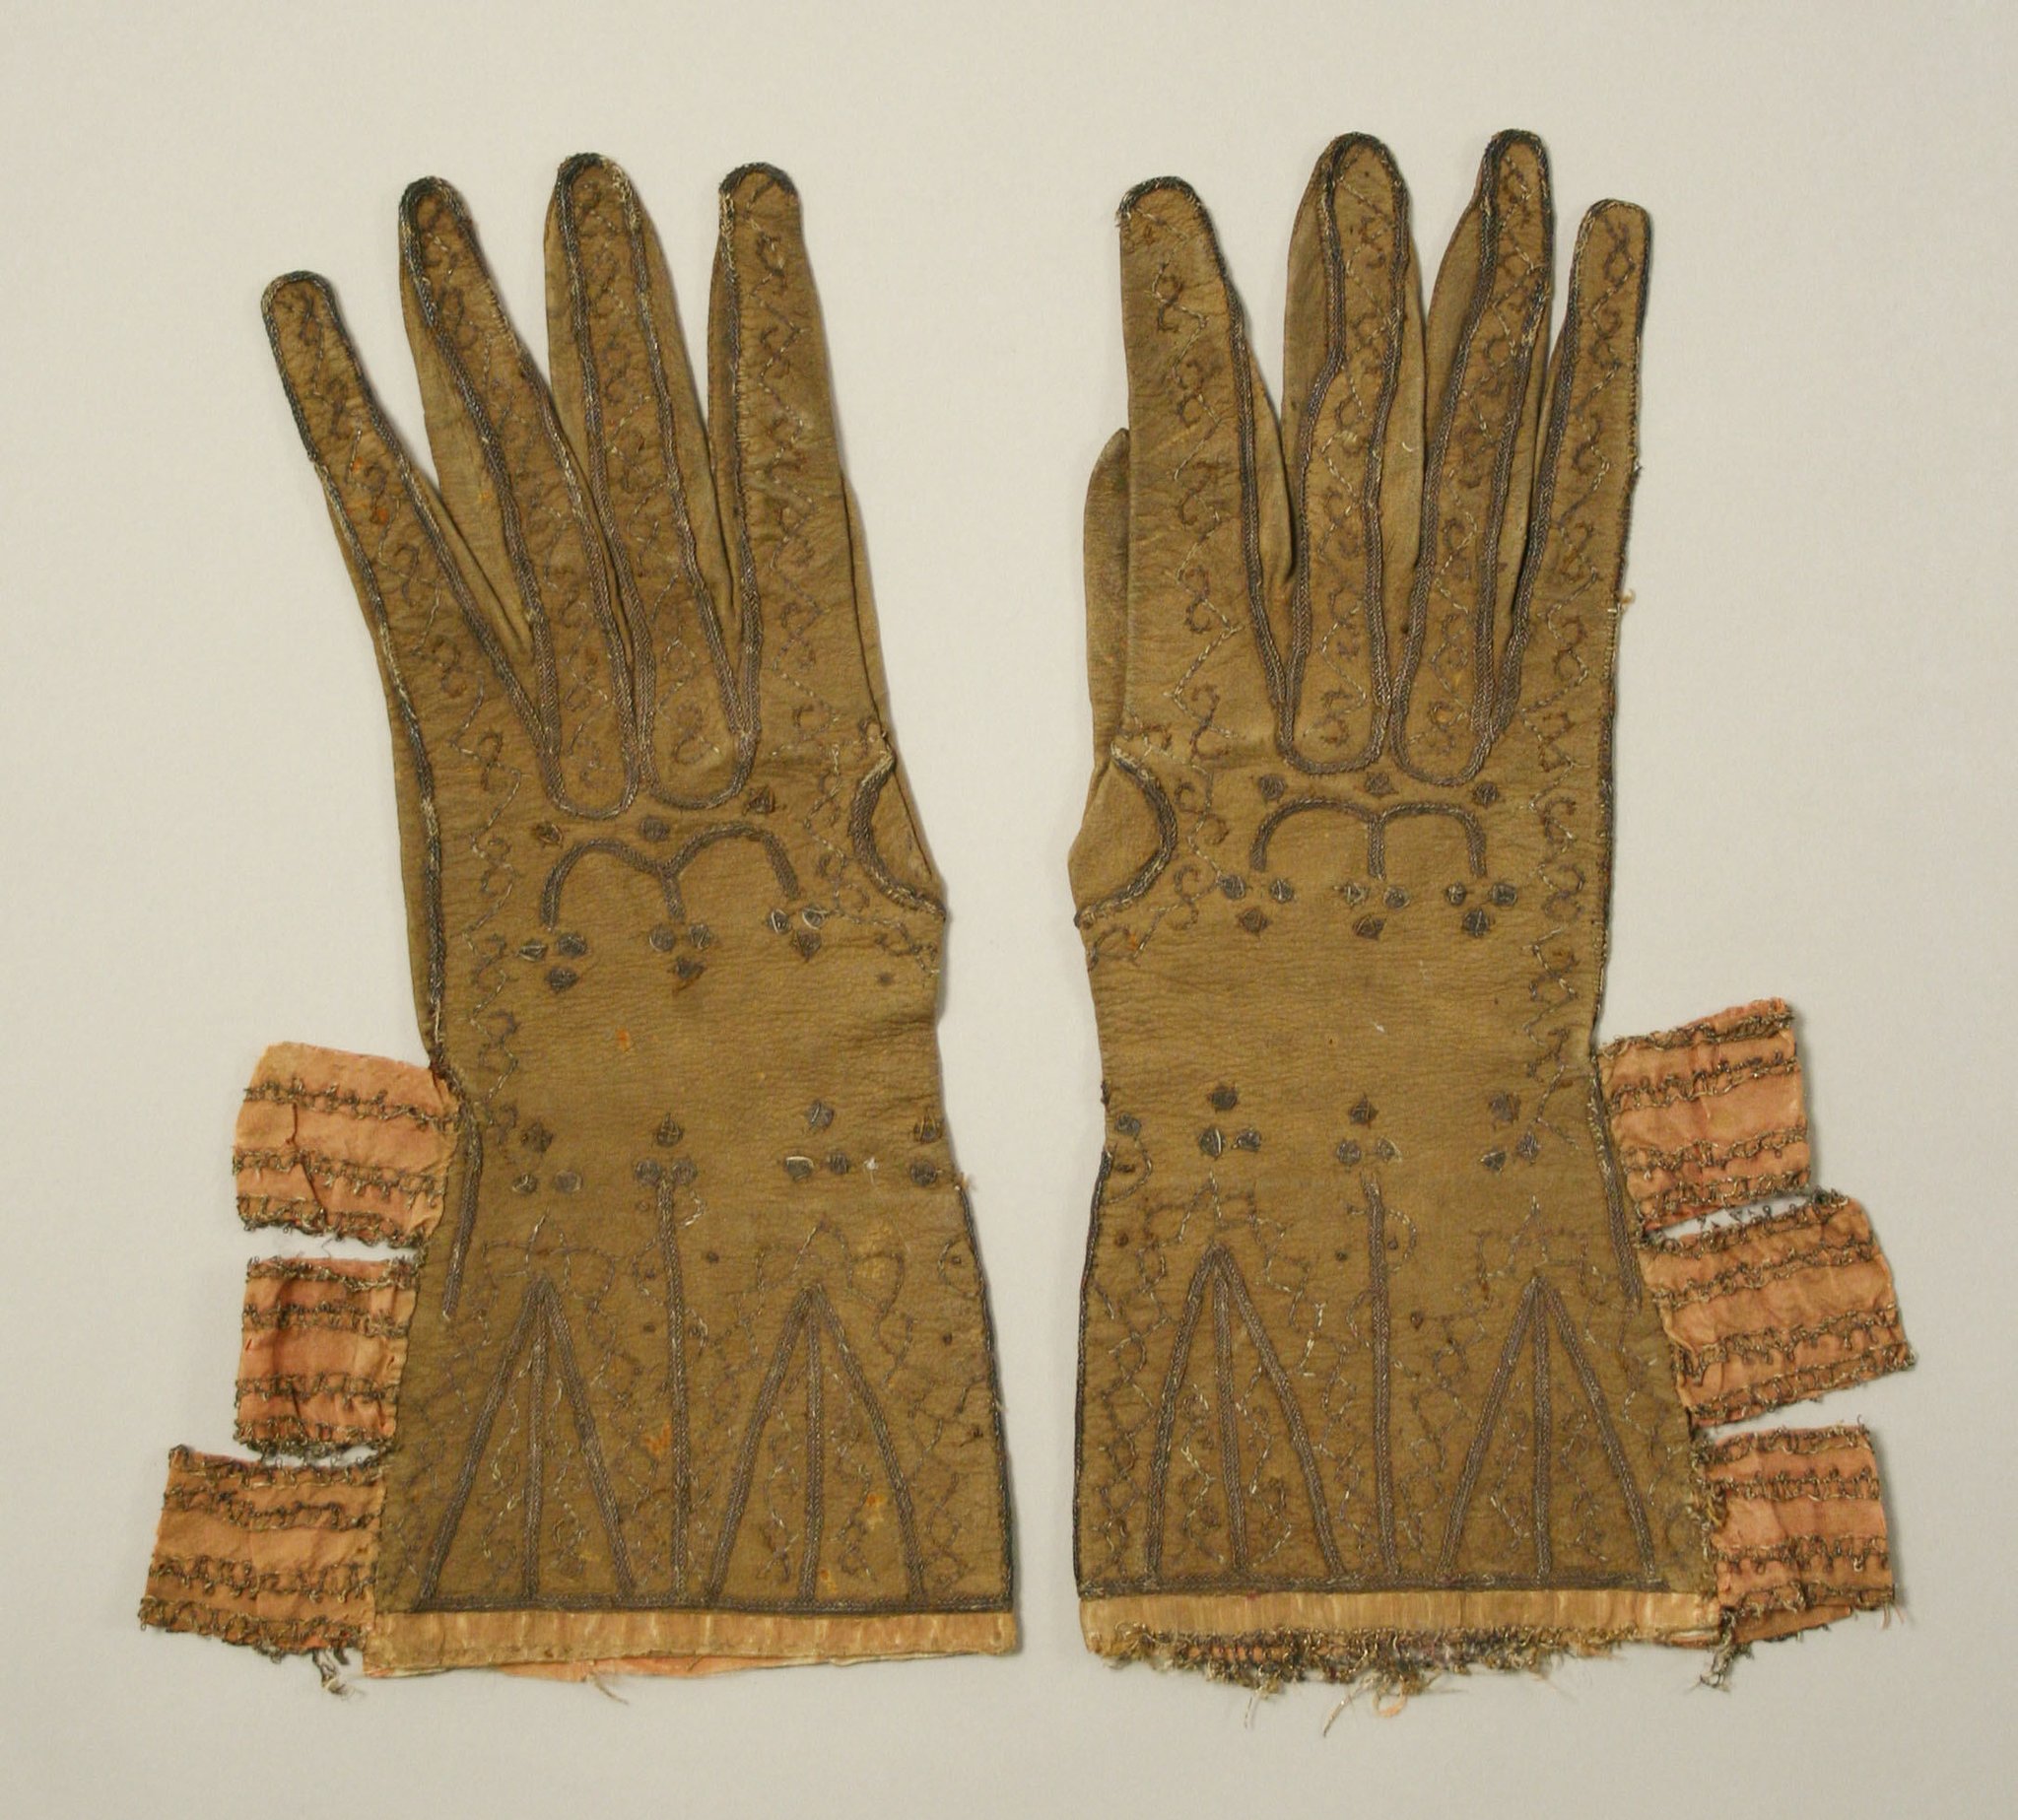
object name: glove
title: Gloves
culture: british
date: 1601-1700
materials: leather